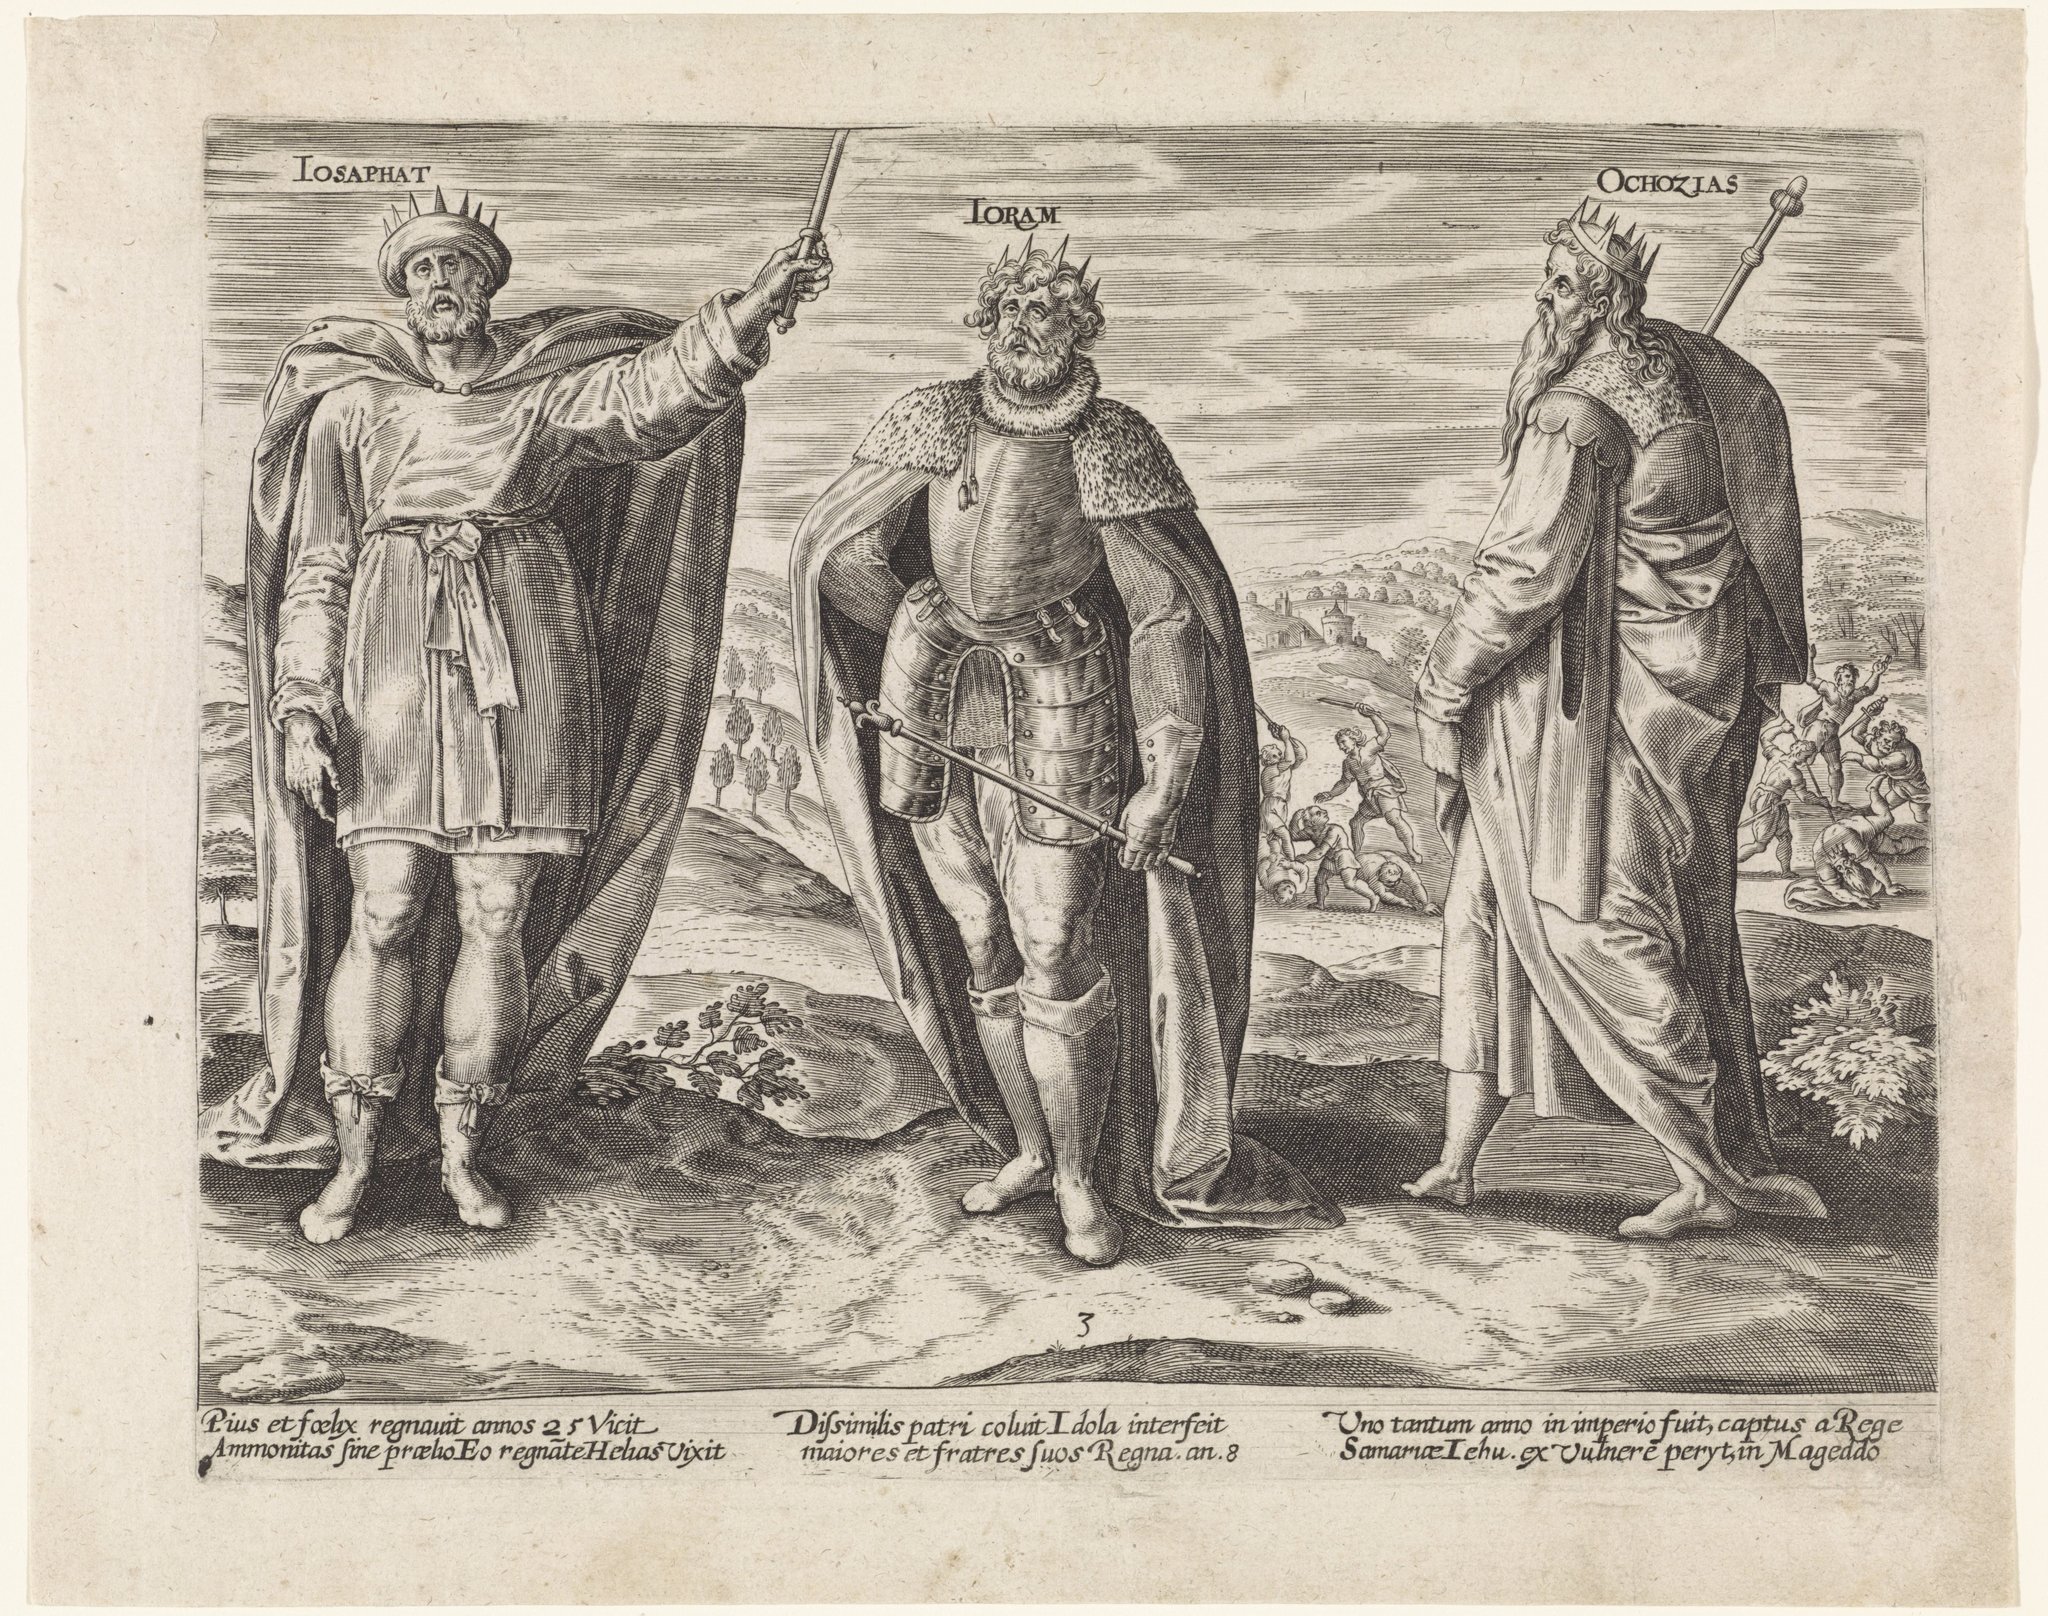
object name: print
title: Josafat, Joram en Achazja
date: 1585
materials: paper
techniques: engraving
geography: antwerp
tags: death of ahaziah, story of ahaziah (ochozias), son of jehoram, king of judah (2 kings 8:25-29; 2 chronicles 22:1-9), story of jehoram (joram), son of jehoshaphat, king of judah (2 kings 8:16-24; 2 chronicles 21), story of jehoshaphat (josaphat), son of asa, king of judah (1 kings 22:41-51; 2 chronicles 17-20), kings of israel and judah ~ the old testament (not in biblical context)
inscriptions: collector's mark: Lugt 2228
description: De koningen Josefat, Joram en Achazja. Op de achtergrond enkele belangrijke gebeurtenissen uit hun leven. Midden op de achtergrond slaan twee mannen met stokken drie kinderen. Rechts op de achtergrond de dood van Achazja. Onder de voorstelling toelichtingen in het Latijn.